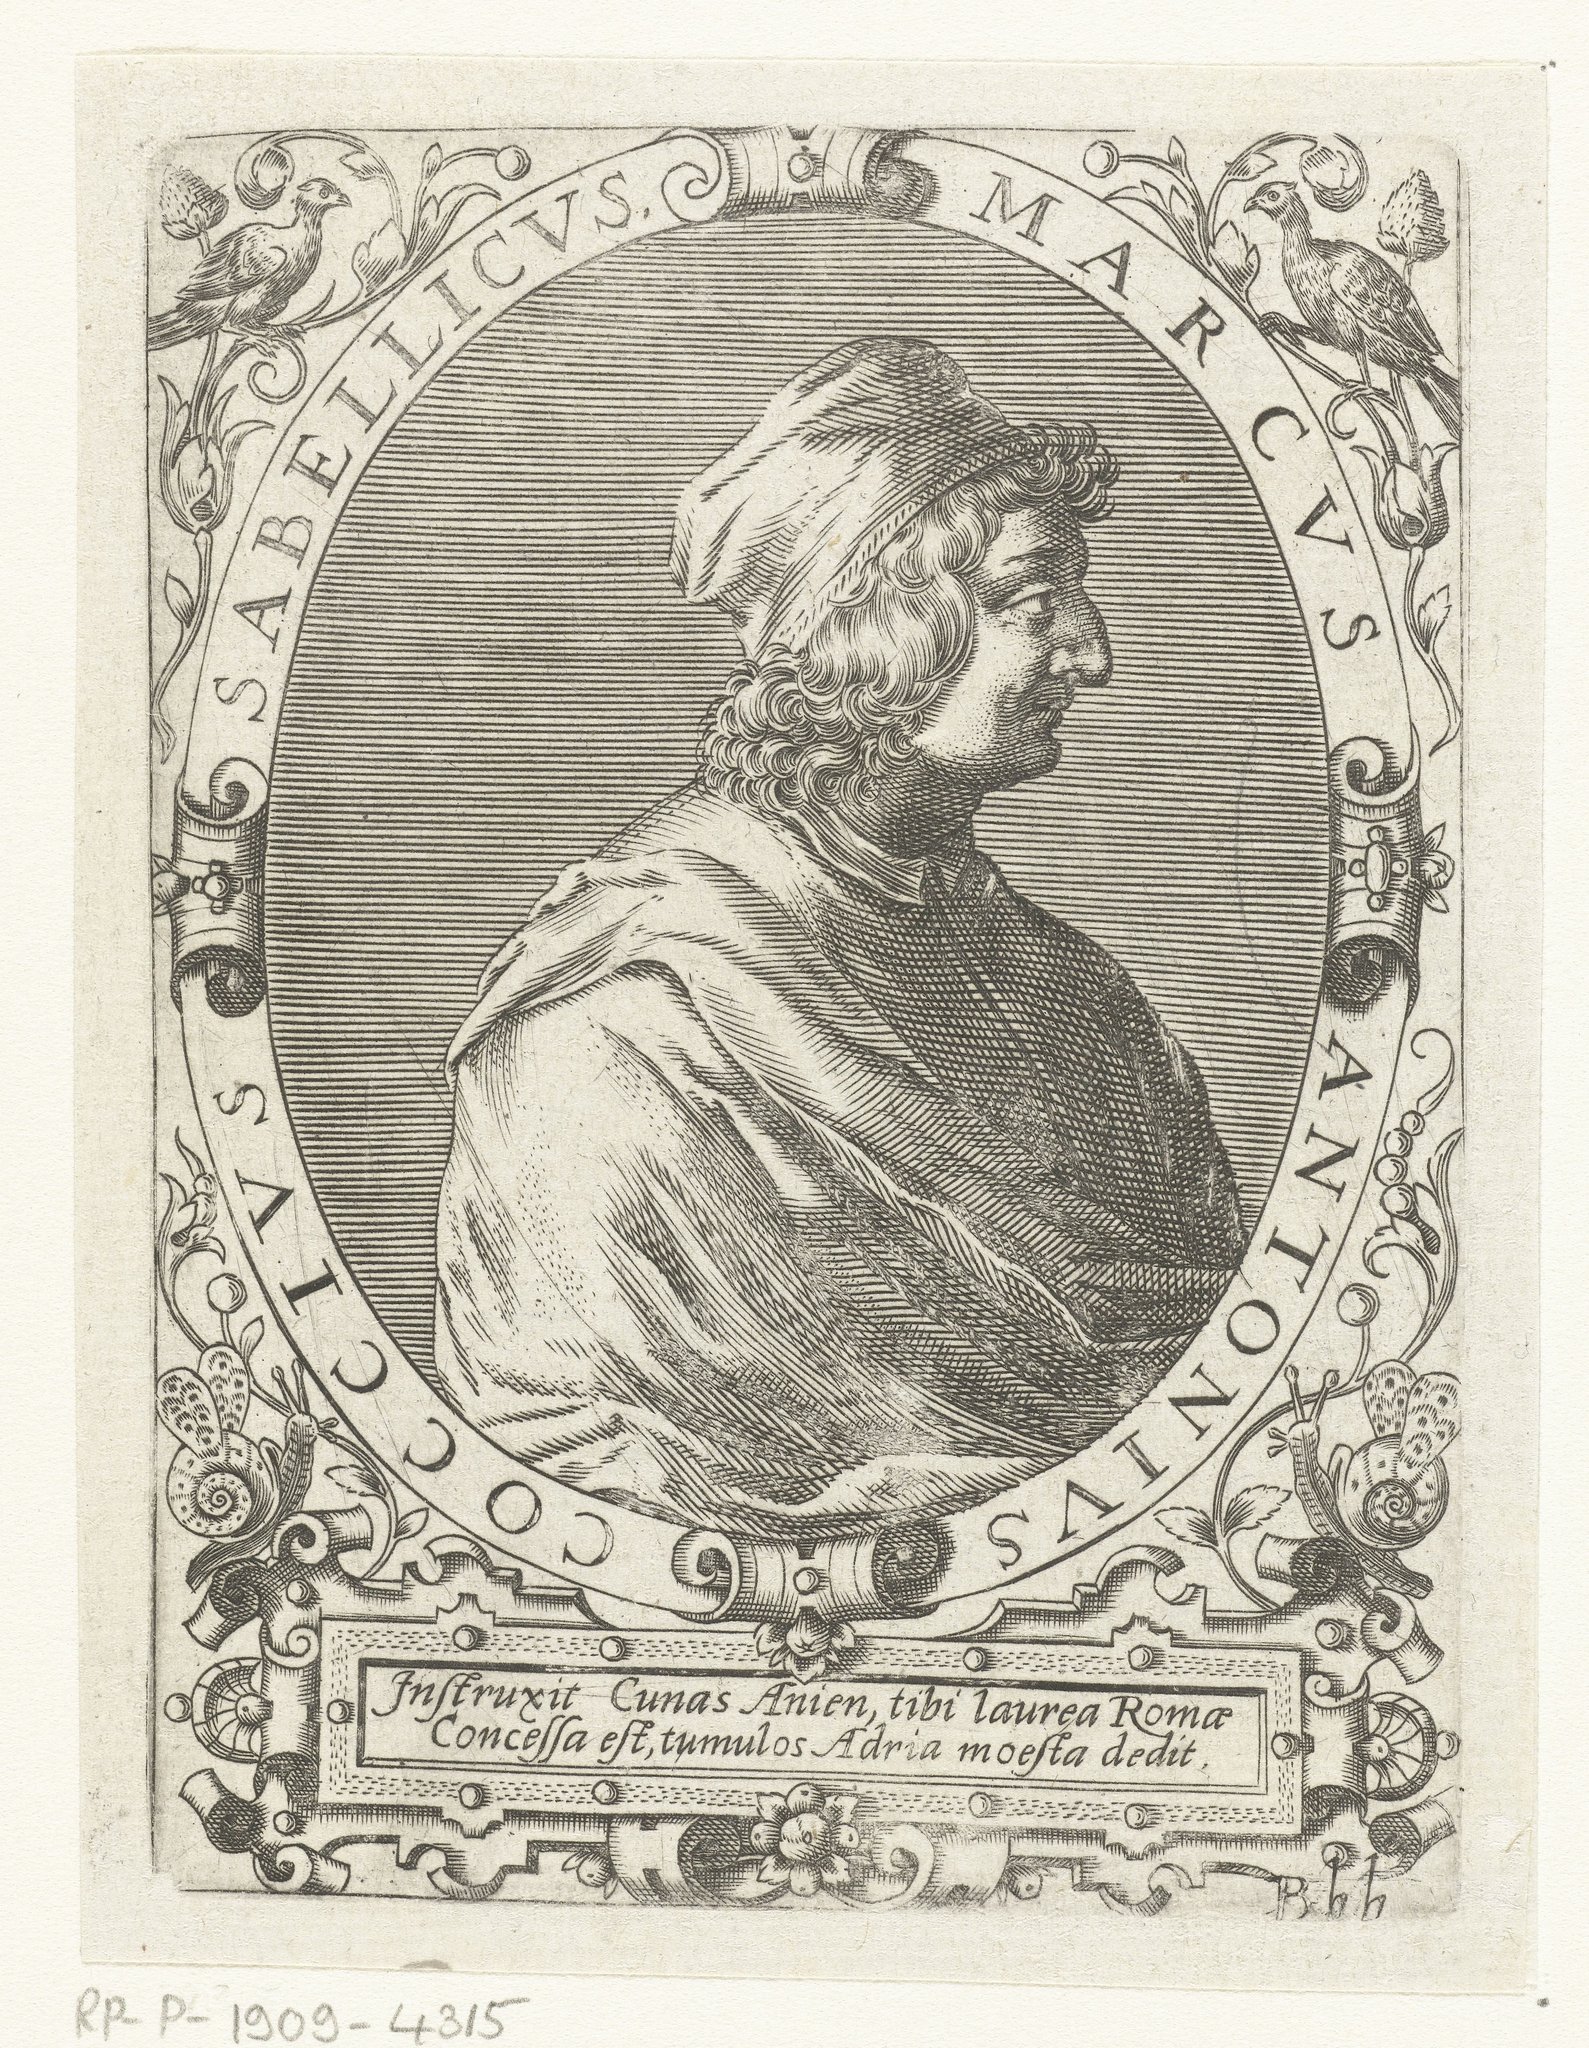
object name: book illustration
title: Marcus Antonius Coccius Sabellicus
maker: jean jacques boissard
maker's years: 1528-1598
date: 1669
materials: paper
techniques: engraving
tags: venice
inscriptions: collector's mark: Lugt 2228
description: Gemaakt voor: J.J. Boissard, Icones virorum illustrium doctrina &c eruditione praestanti um contines. Frankfurt am Main: de Bry, 1597-1599. Opnieuw gebruikt in: J.J.Boissard, Bibliotheca chalcographica, hoc est Virtute et eruditione clarorum Virorum Imagines. Heidelberg: Clemens Ammon, 1669. Dl. 1-5 (te herkennen aan de toegevoegde signatuur in de rechter onderhoek: 3B).